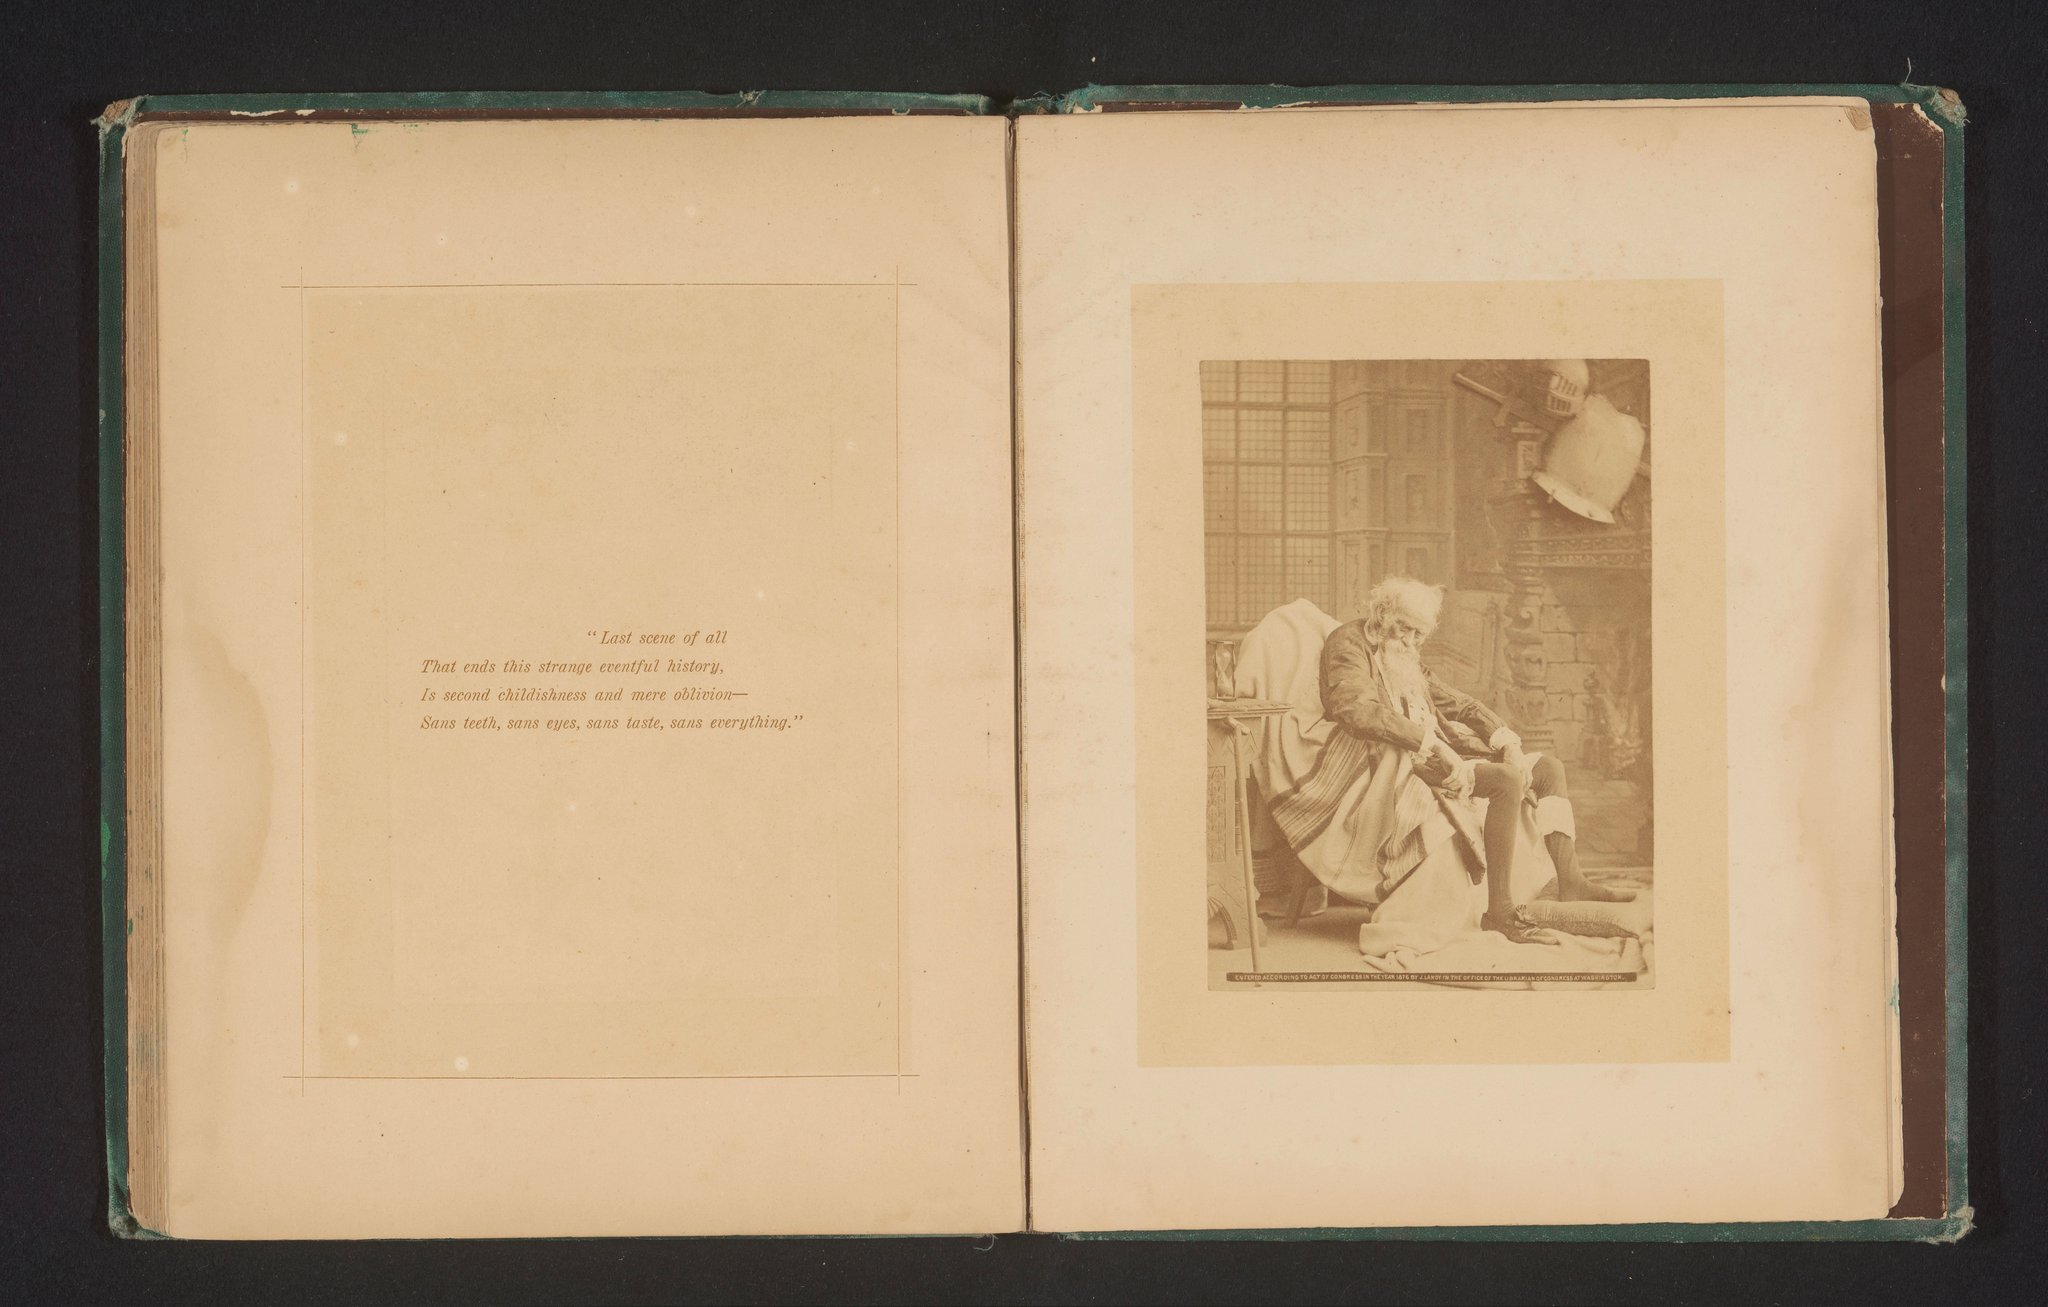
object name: page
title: Oudere man uit The seven ages of man - As you like it van William Shakespeare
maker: james m. landy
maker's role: fotograaf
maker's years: 1838-1897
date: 1872-1877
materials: photographic support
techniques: albumen print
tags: theatre, theatrical performance, adult man, historical persons